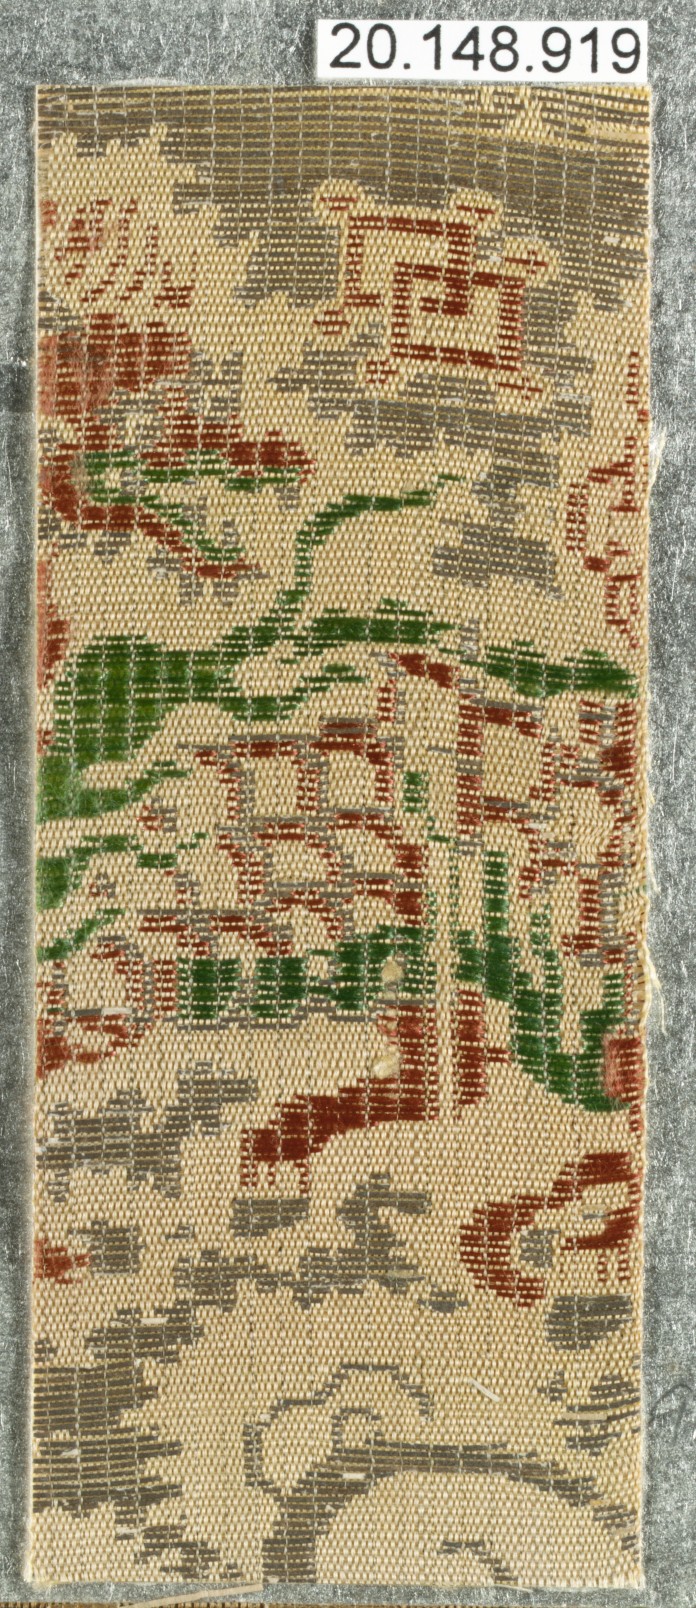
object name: piece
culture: japanese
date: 1701-1800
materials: silk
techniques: compound weave